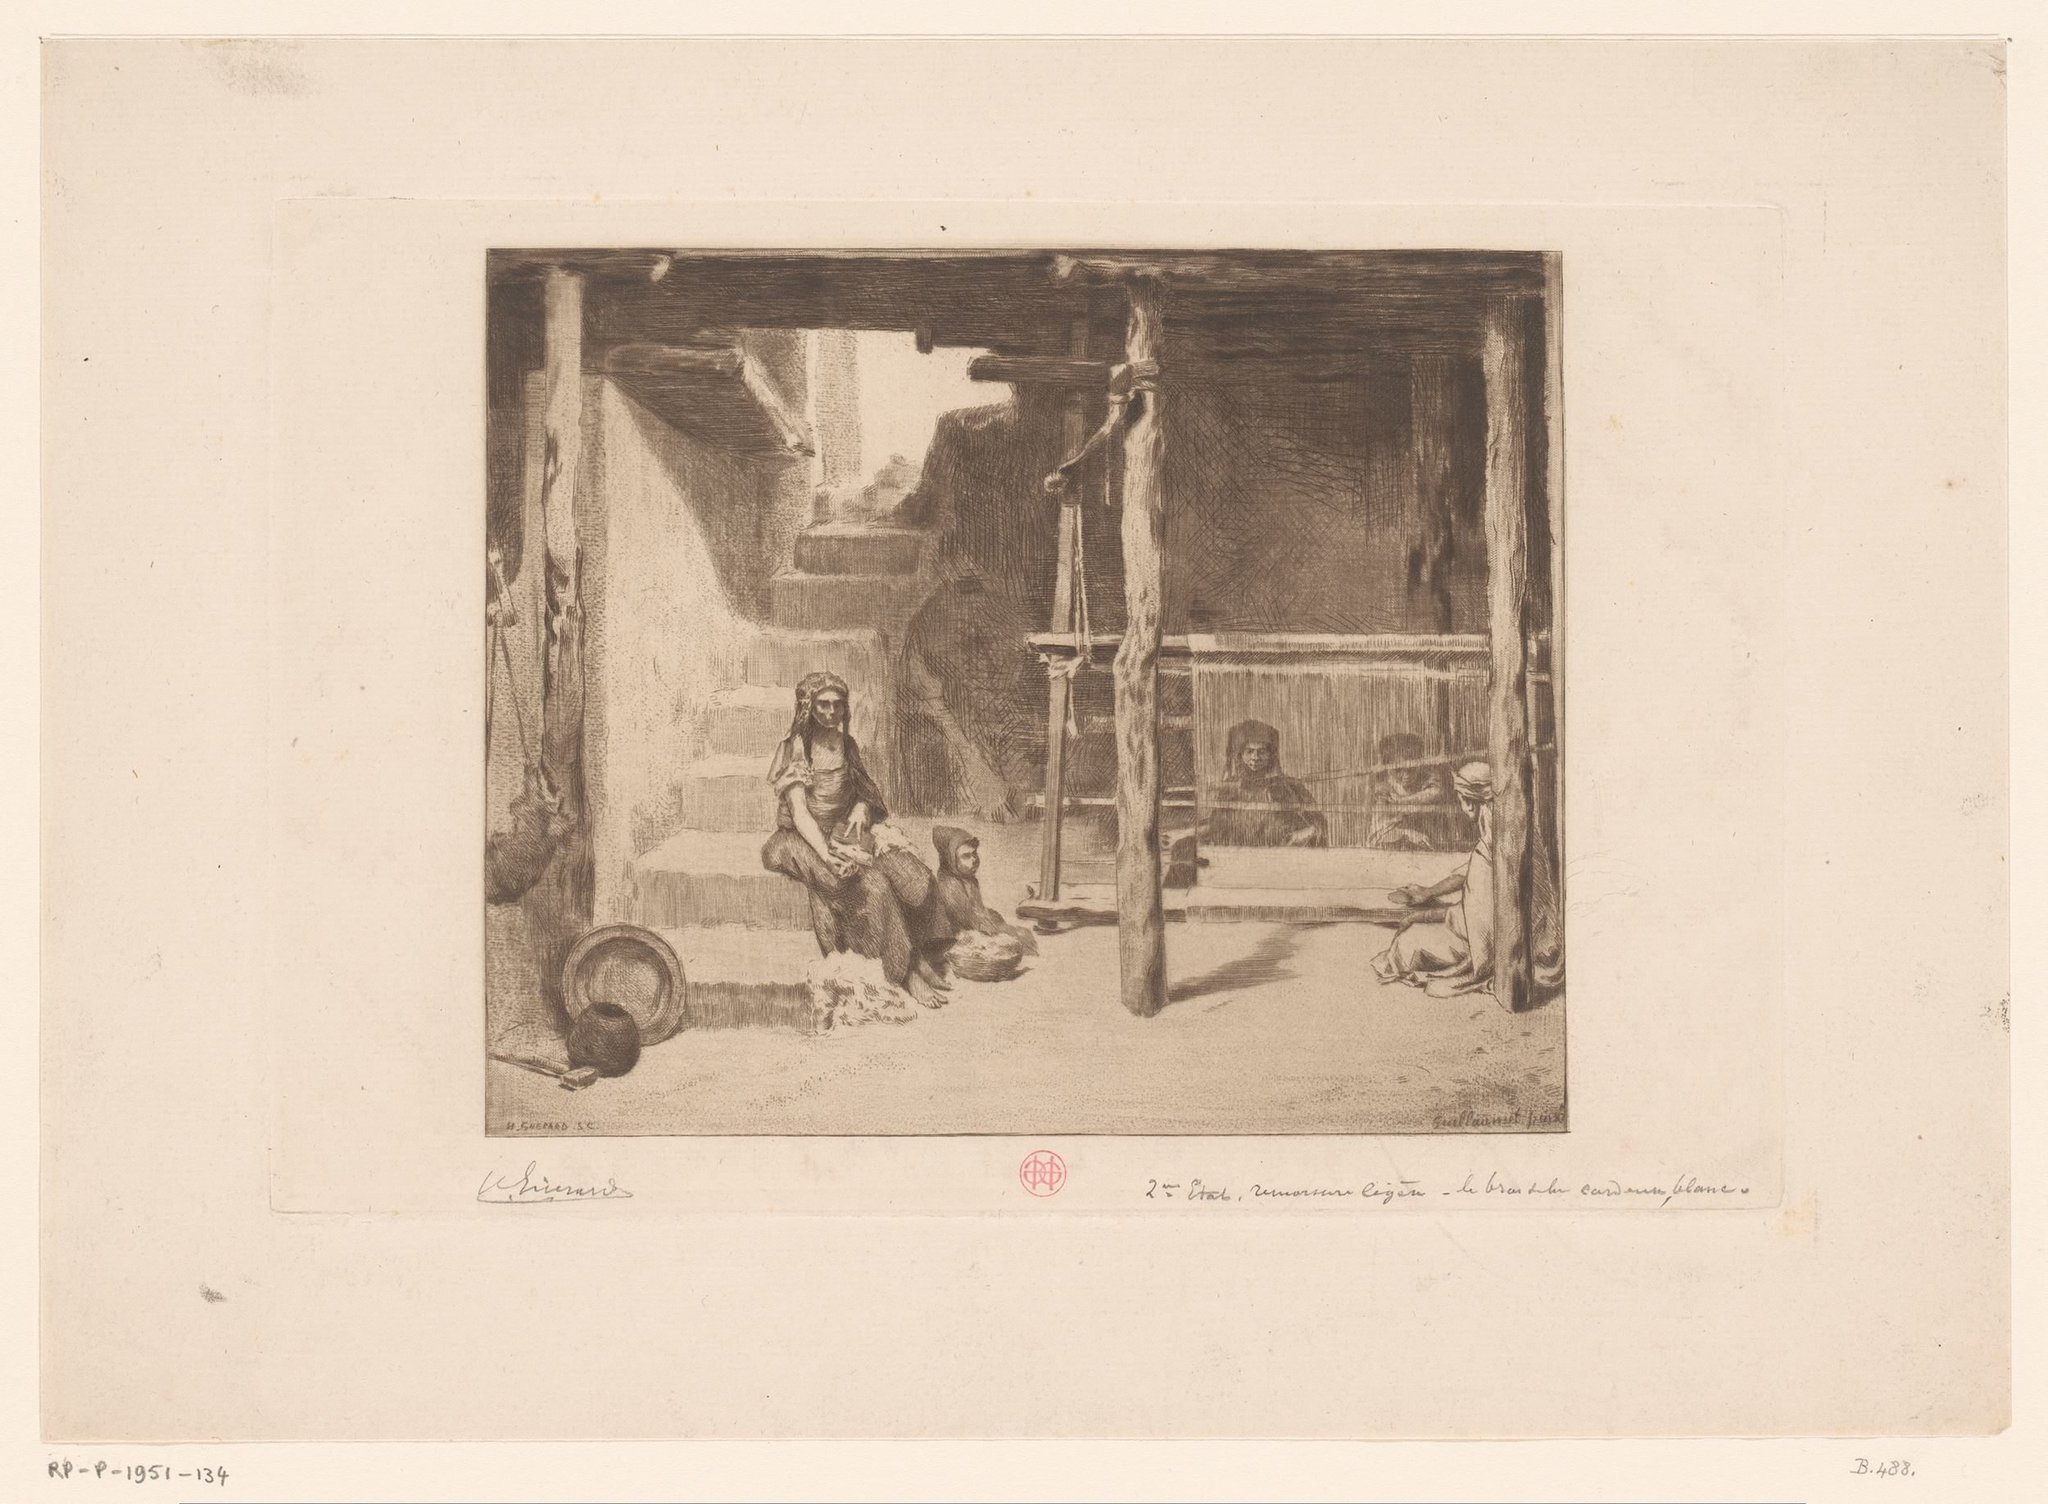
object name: print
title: Arabische wevers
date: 1887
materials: paper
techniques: etching, roulette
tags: weaving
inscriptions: annotation: ‘2eme. Etat [...]’, stamp: Lugt 1157, collector's mark: Lugt 2228